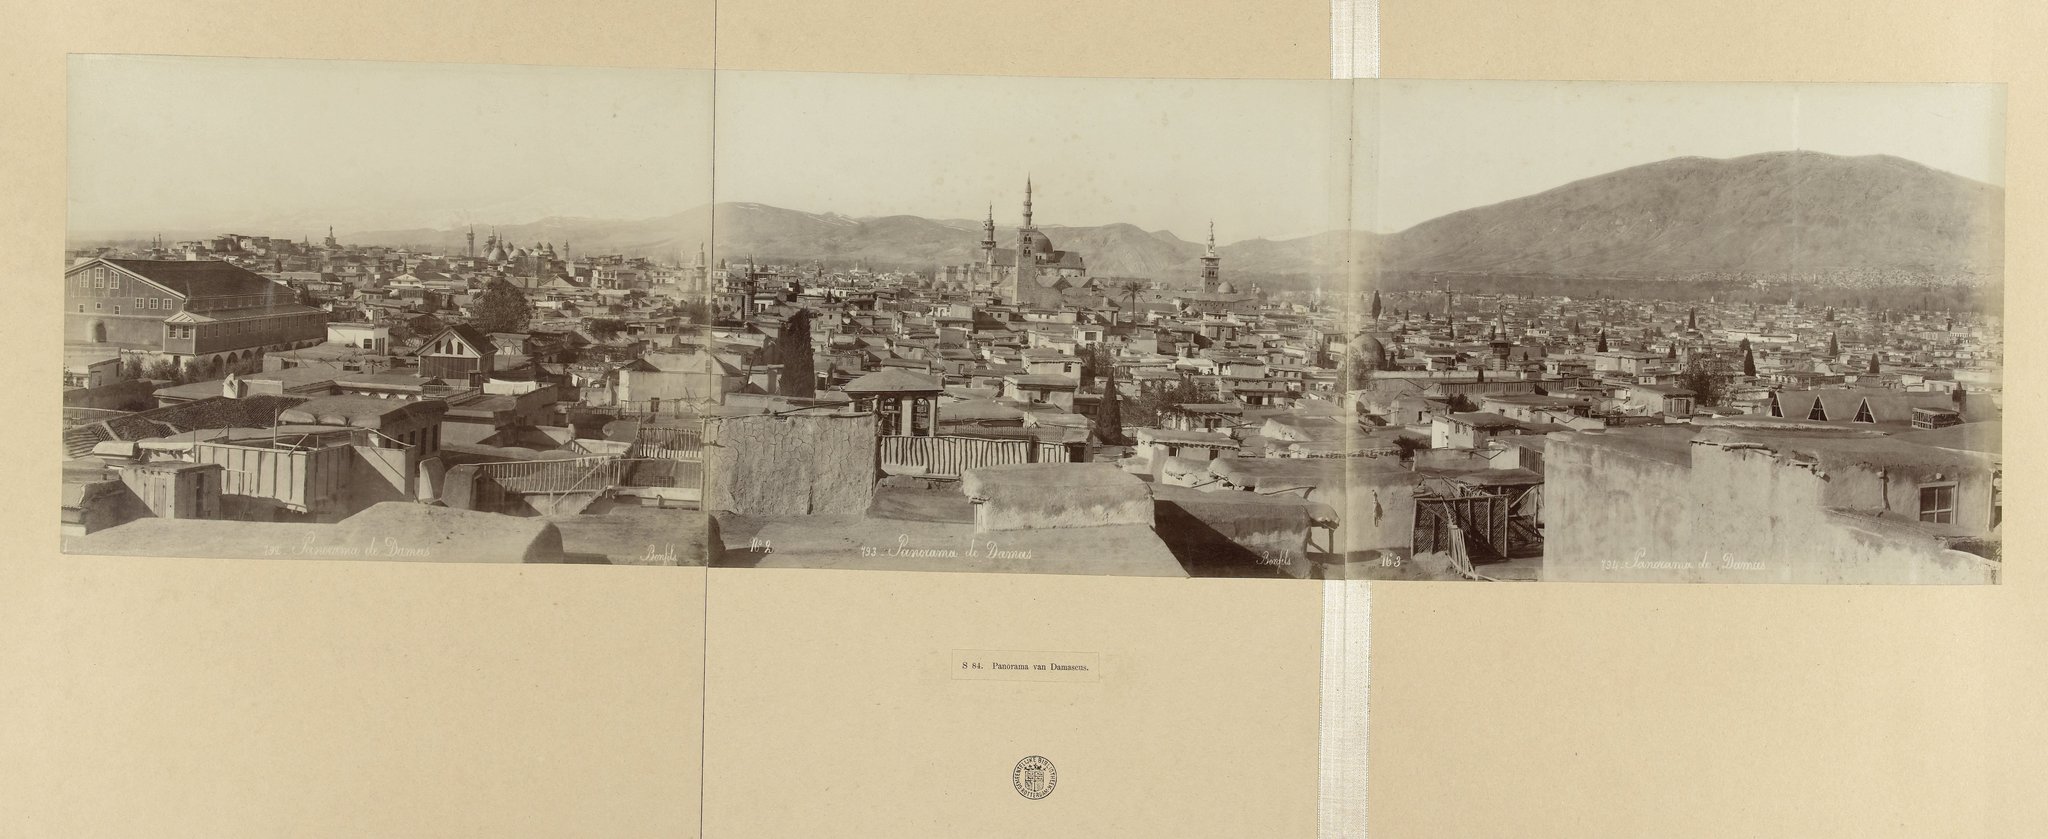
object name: photograph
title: Panorama van Damascus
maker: félix bonfils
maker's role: fotograaf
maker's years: 1831-1885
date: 1867-1877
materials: cardboard, paper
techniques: albumen print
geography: ottoman empire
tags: city-view in general; 'veduta'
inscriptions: title: ‘S 84. Panorama van Damascus.’, stamp: ‘Gemeentelijke bibliotheek/ Rotterdam’, number: ‘1 792/ No 2 793/ No 3 794’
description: Onderdeel van een groep door fotograaf Richard Polak op reis verzamelde foto’s. Deze foto is samen met andere op zijn reizen verzamelde foto's tentoongesteld bij de Rotterdamsche Kunstkring (1895), Arti en Amicitiae te Amsterdam (1897-1898?) en Societeit 't Collegie te Kampen (datum vooralsnog onbekend).